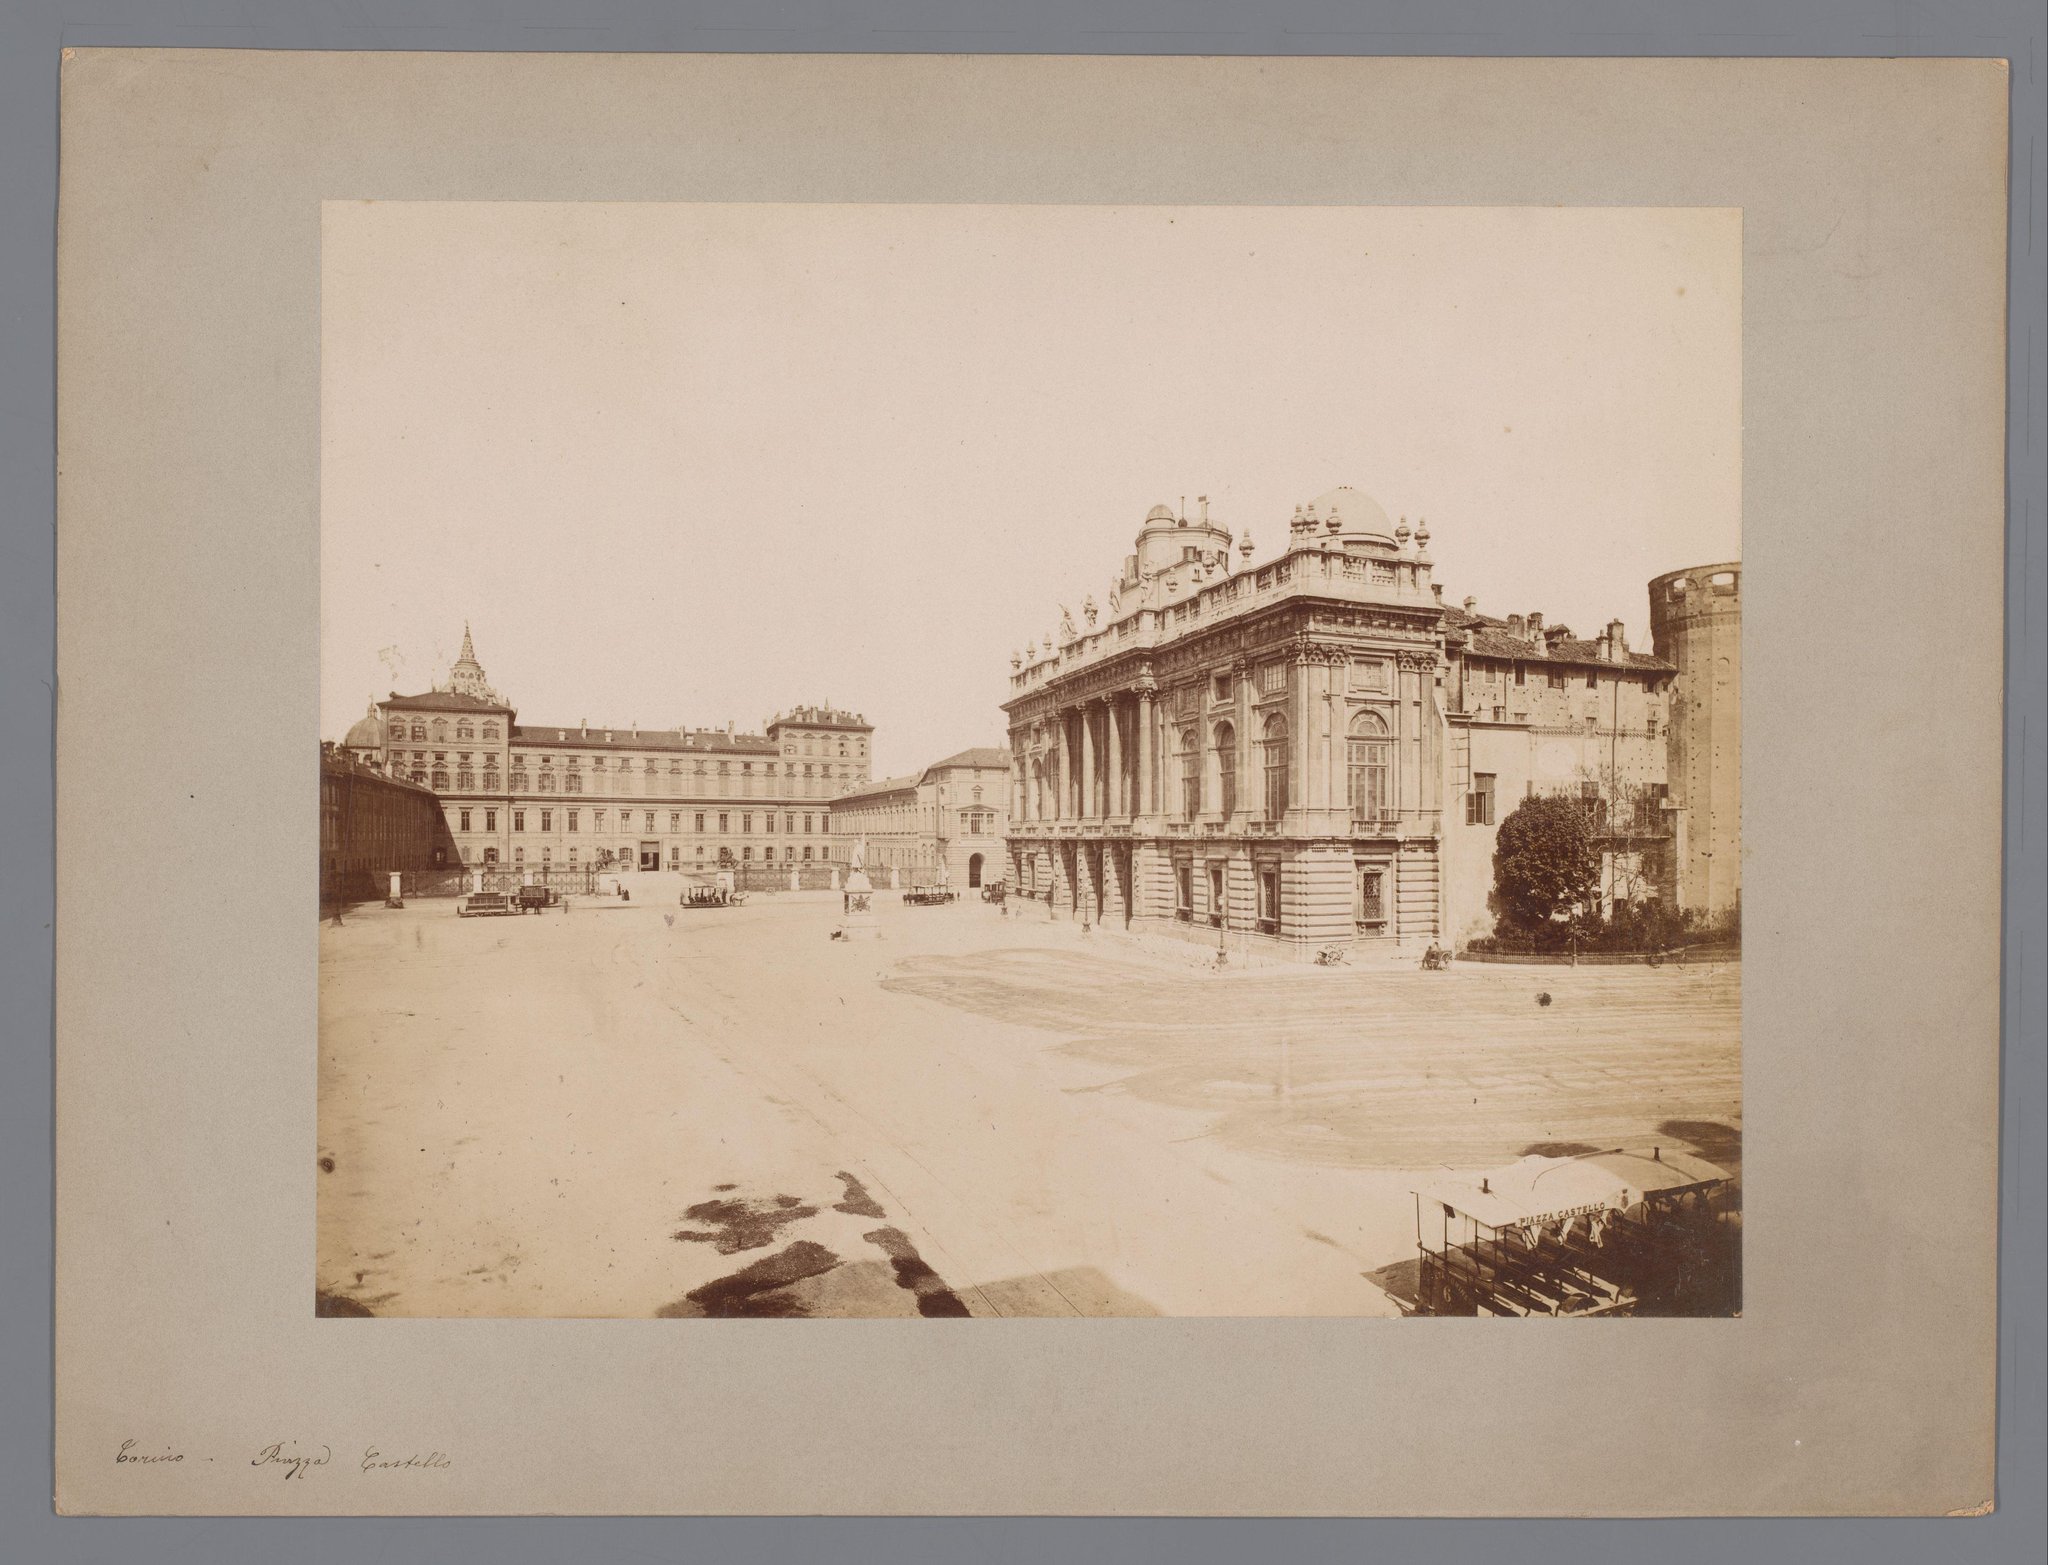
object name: photograph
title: Gezicht op het Piazza Castello te Turijn, Italië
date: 1899-1910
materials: cardboard, paper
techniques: albumen print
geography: turin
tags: square, place, circus, etc., exterior ~ representation of a building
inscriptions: address: ‘VIA GERRAIA CORSO SICCARDI/ TORINO’